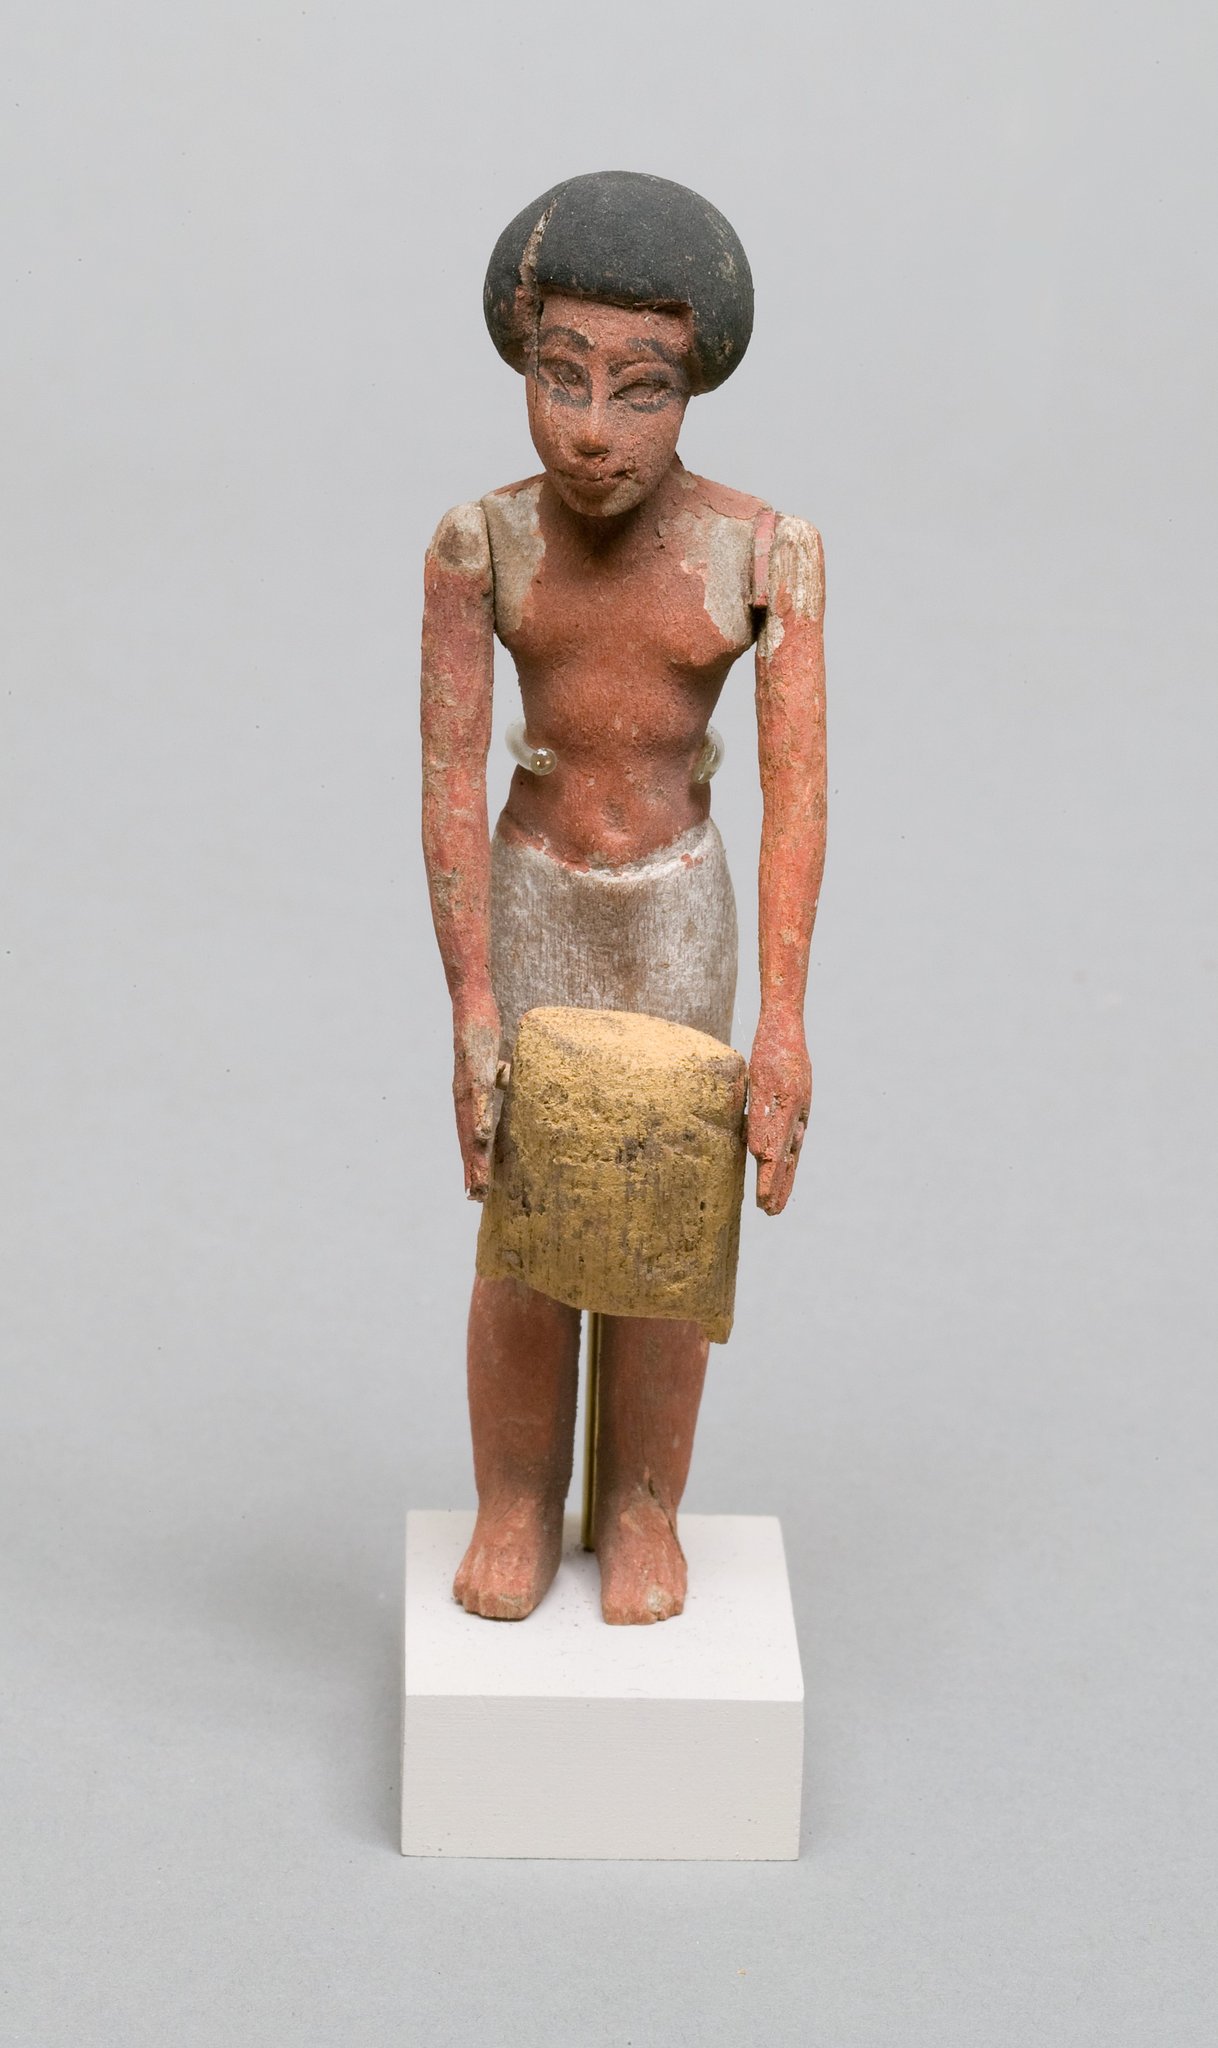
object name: model domestic figure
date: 1981-1640 BCE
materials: paint, wood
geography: egypt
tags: men